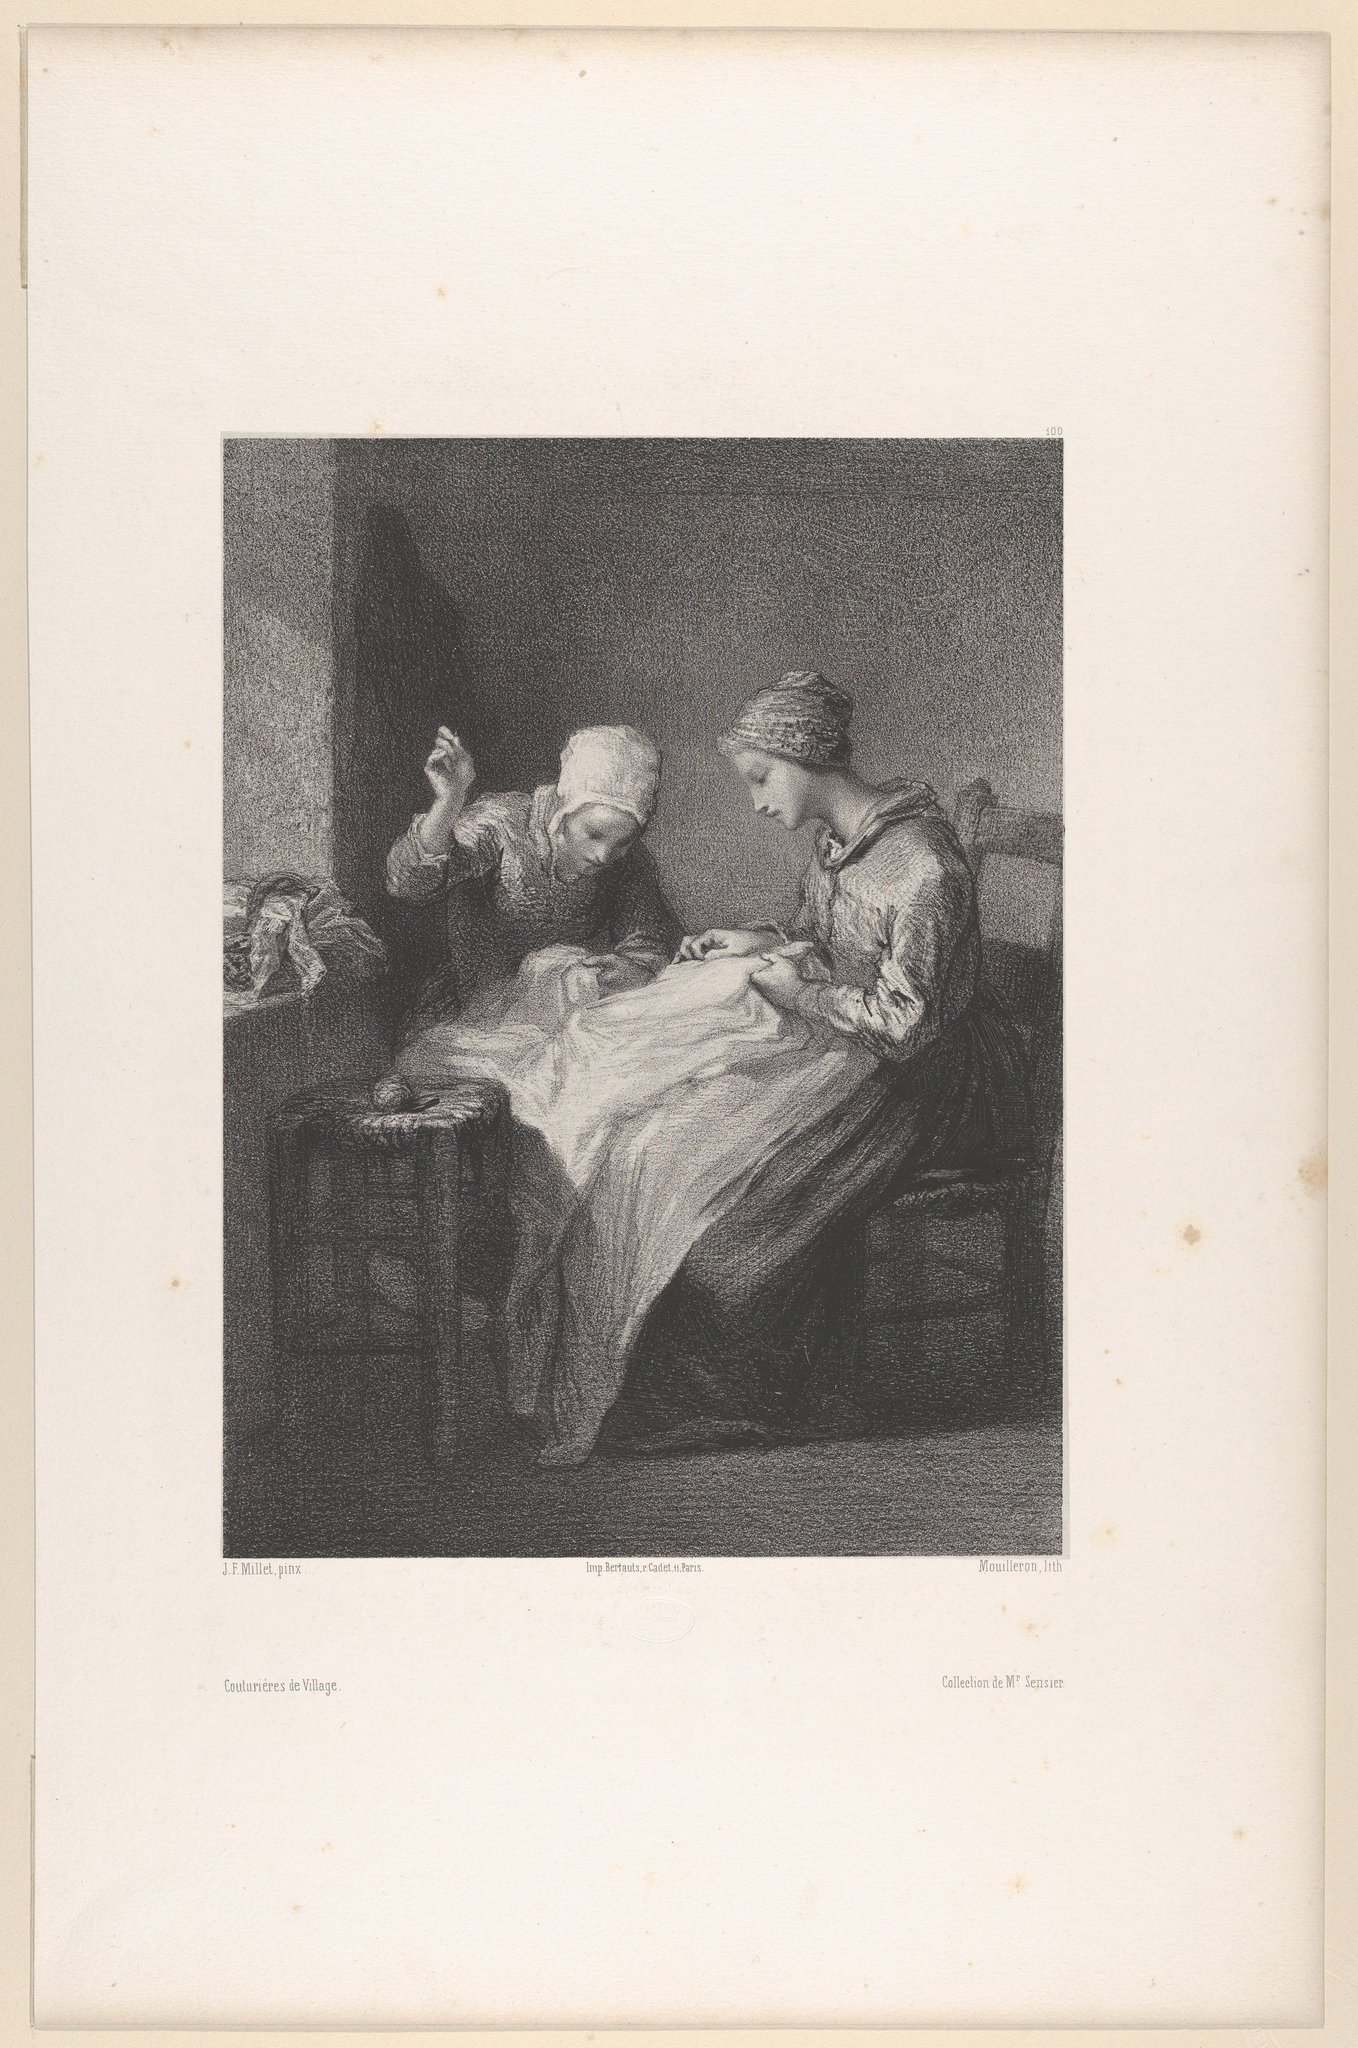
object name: print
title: The Village Dressmakers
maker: jean-françois millet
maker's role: artist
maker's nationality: french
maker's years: 1814-1875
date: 1835-1900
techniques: lithograph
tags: women,working